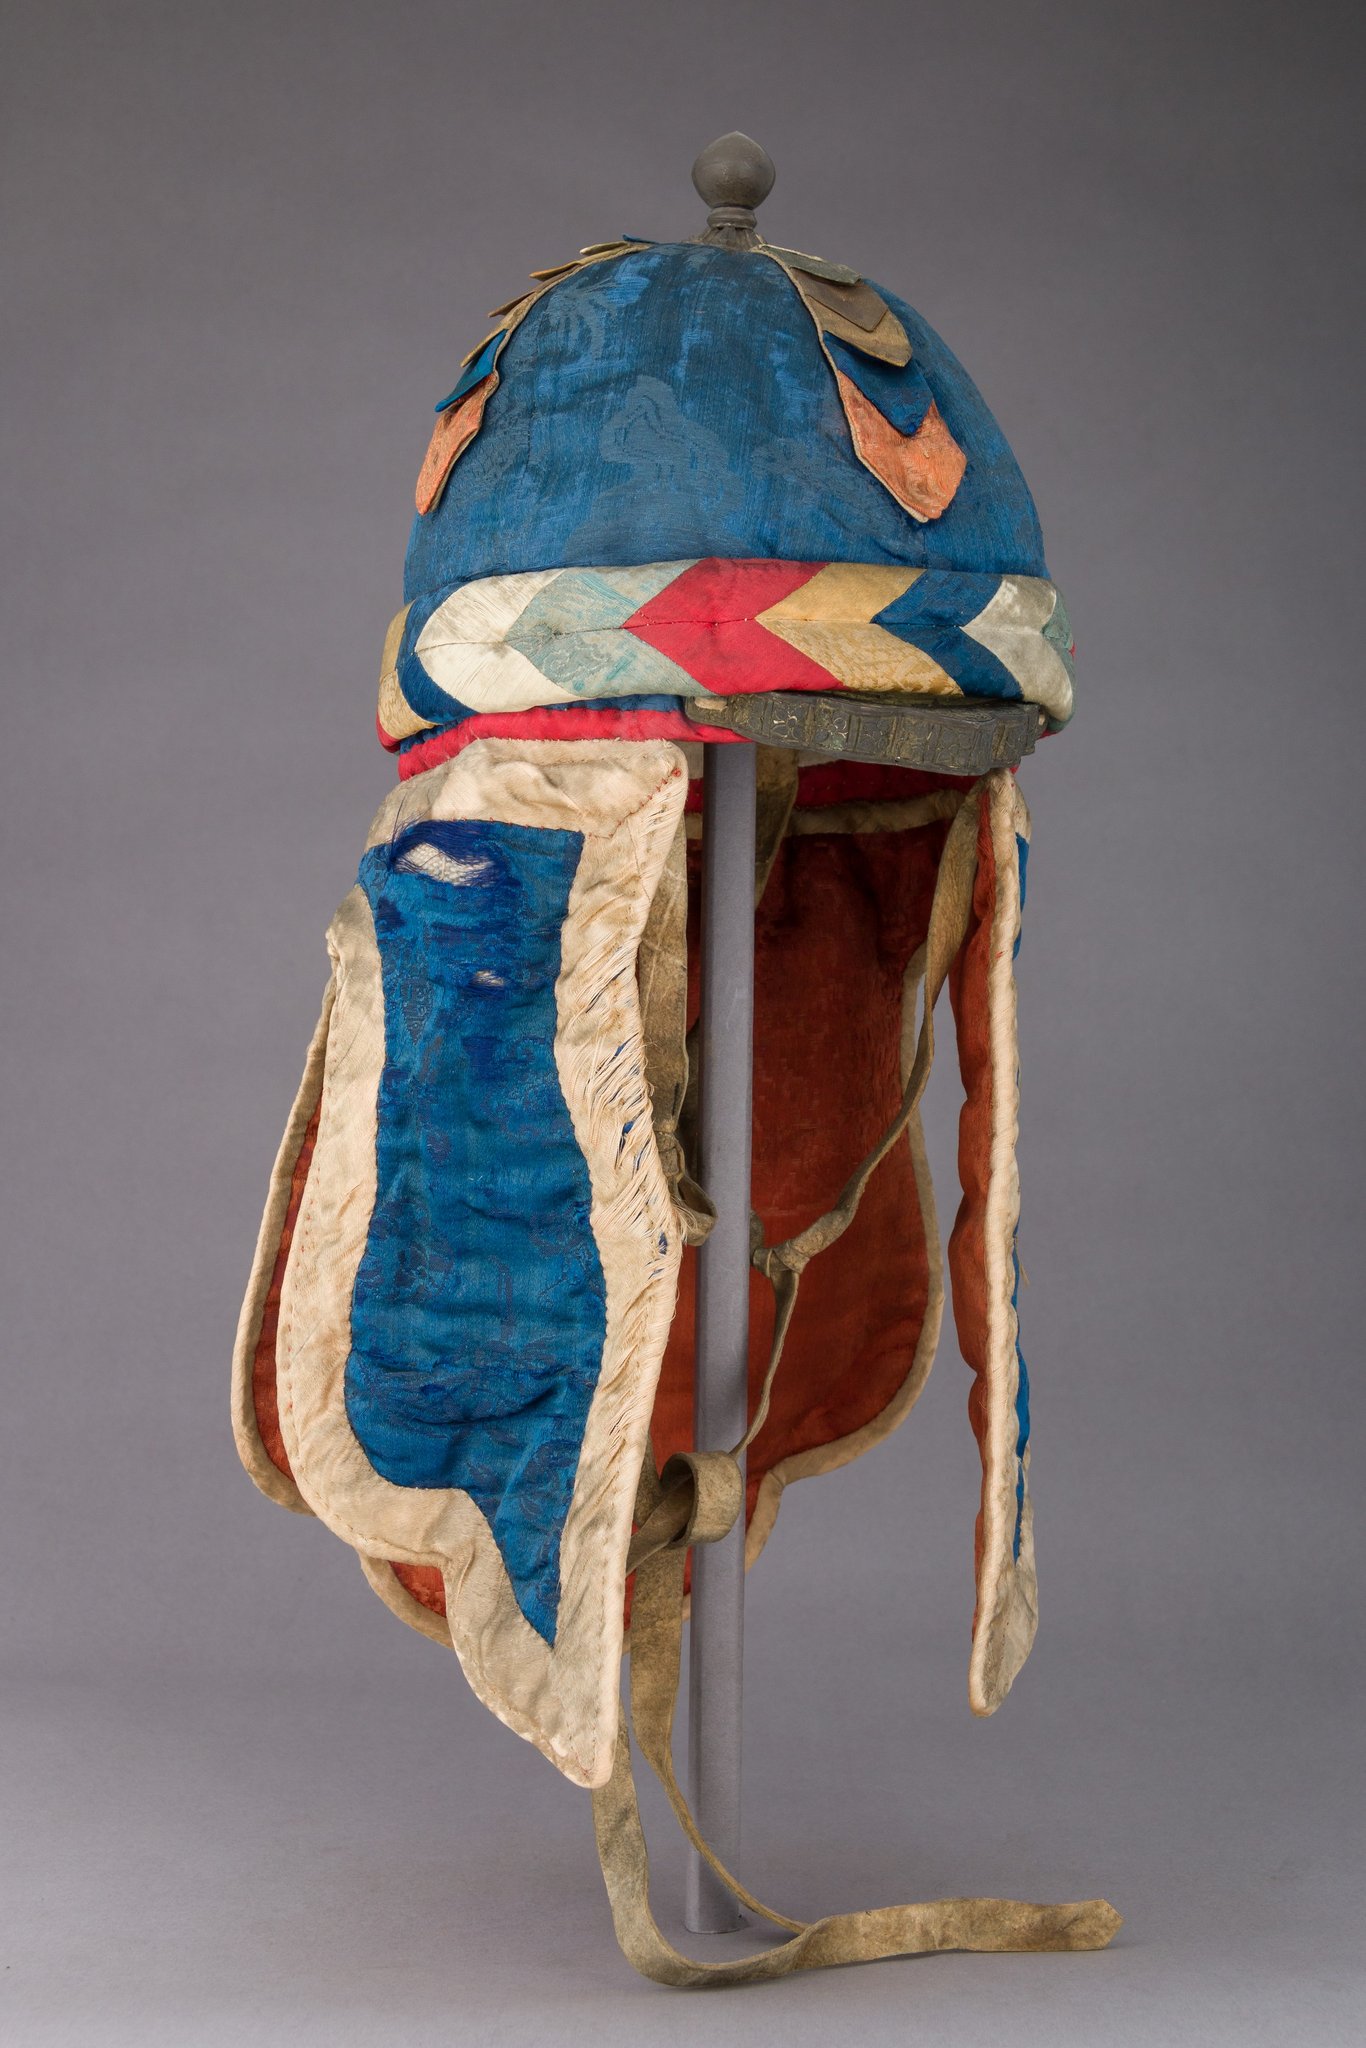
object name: helmet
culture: bhutanese or indian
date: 1801-1900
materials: brass, silk, silver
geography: bhutan